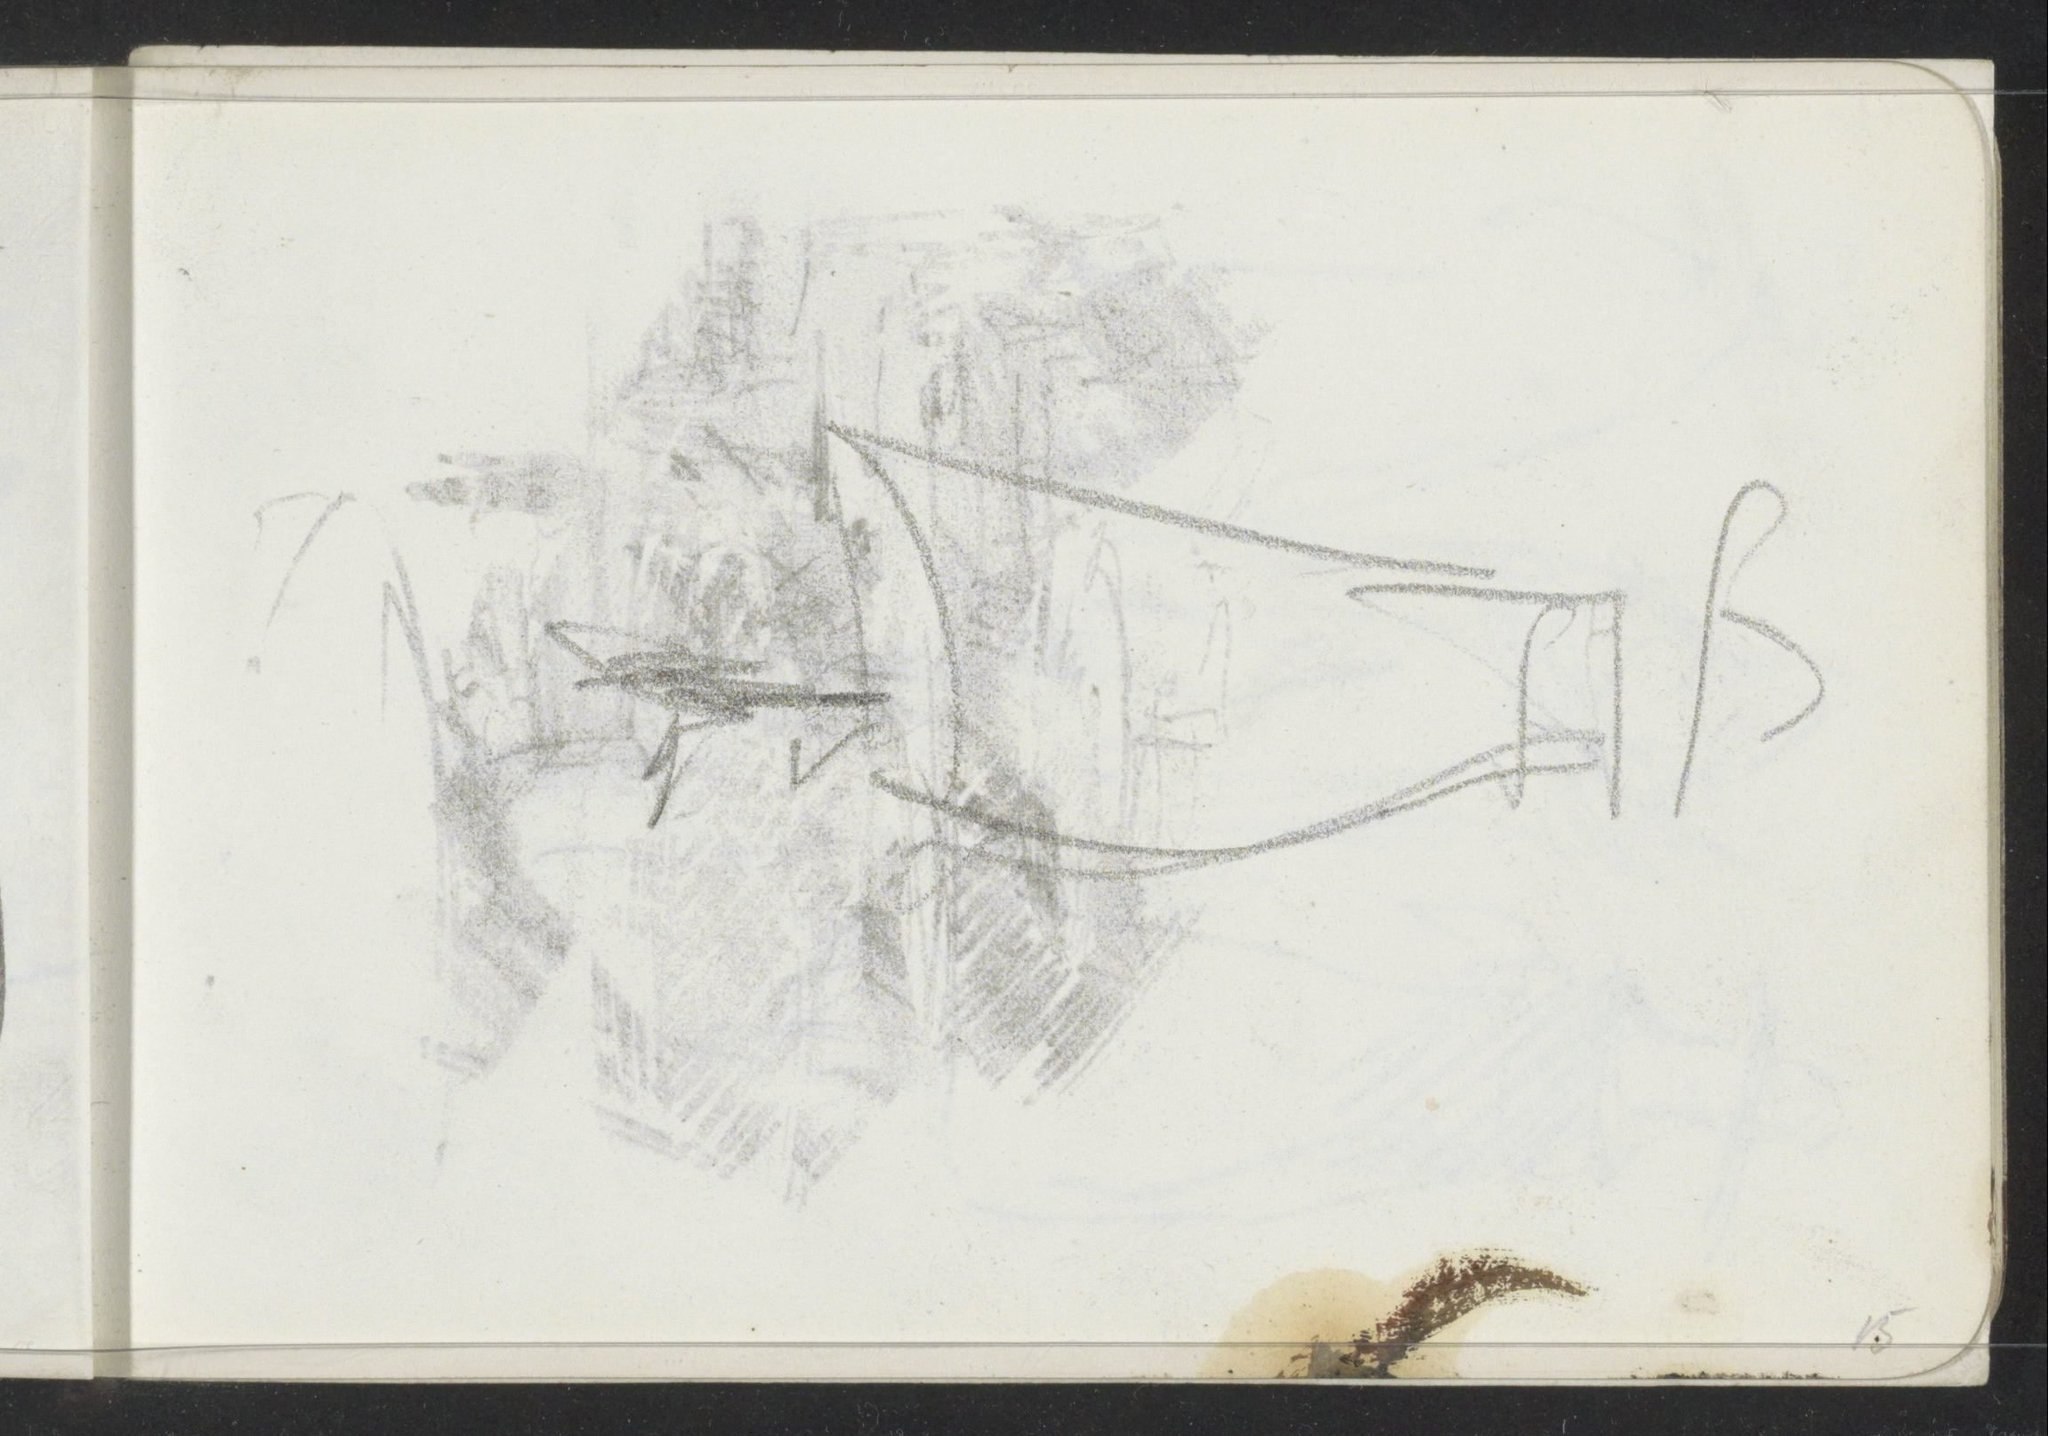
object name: sketchbook leaf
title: Staande vrouw met hoed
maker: isaac israels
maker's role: draughtsman, painter, print maker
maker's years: 1865-1934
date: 1875-1934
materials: paper, pencil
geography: the hague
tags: adult woman (+ standing)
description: Blad 15 recto uit schetsboek LX met 33 bladen.